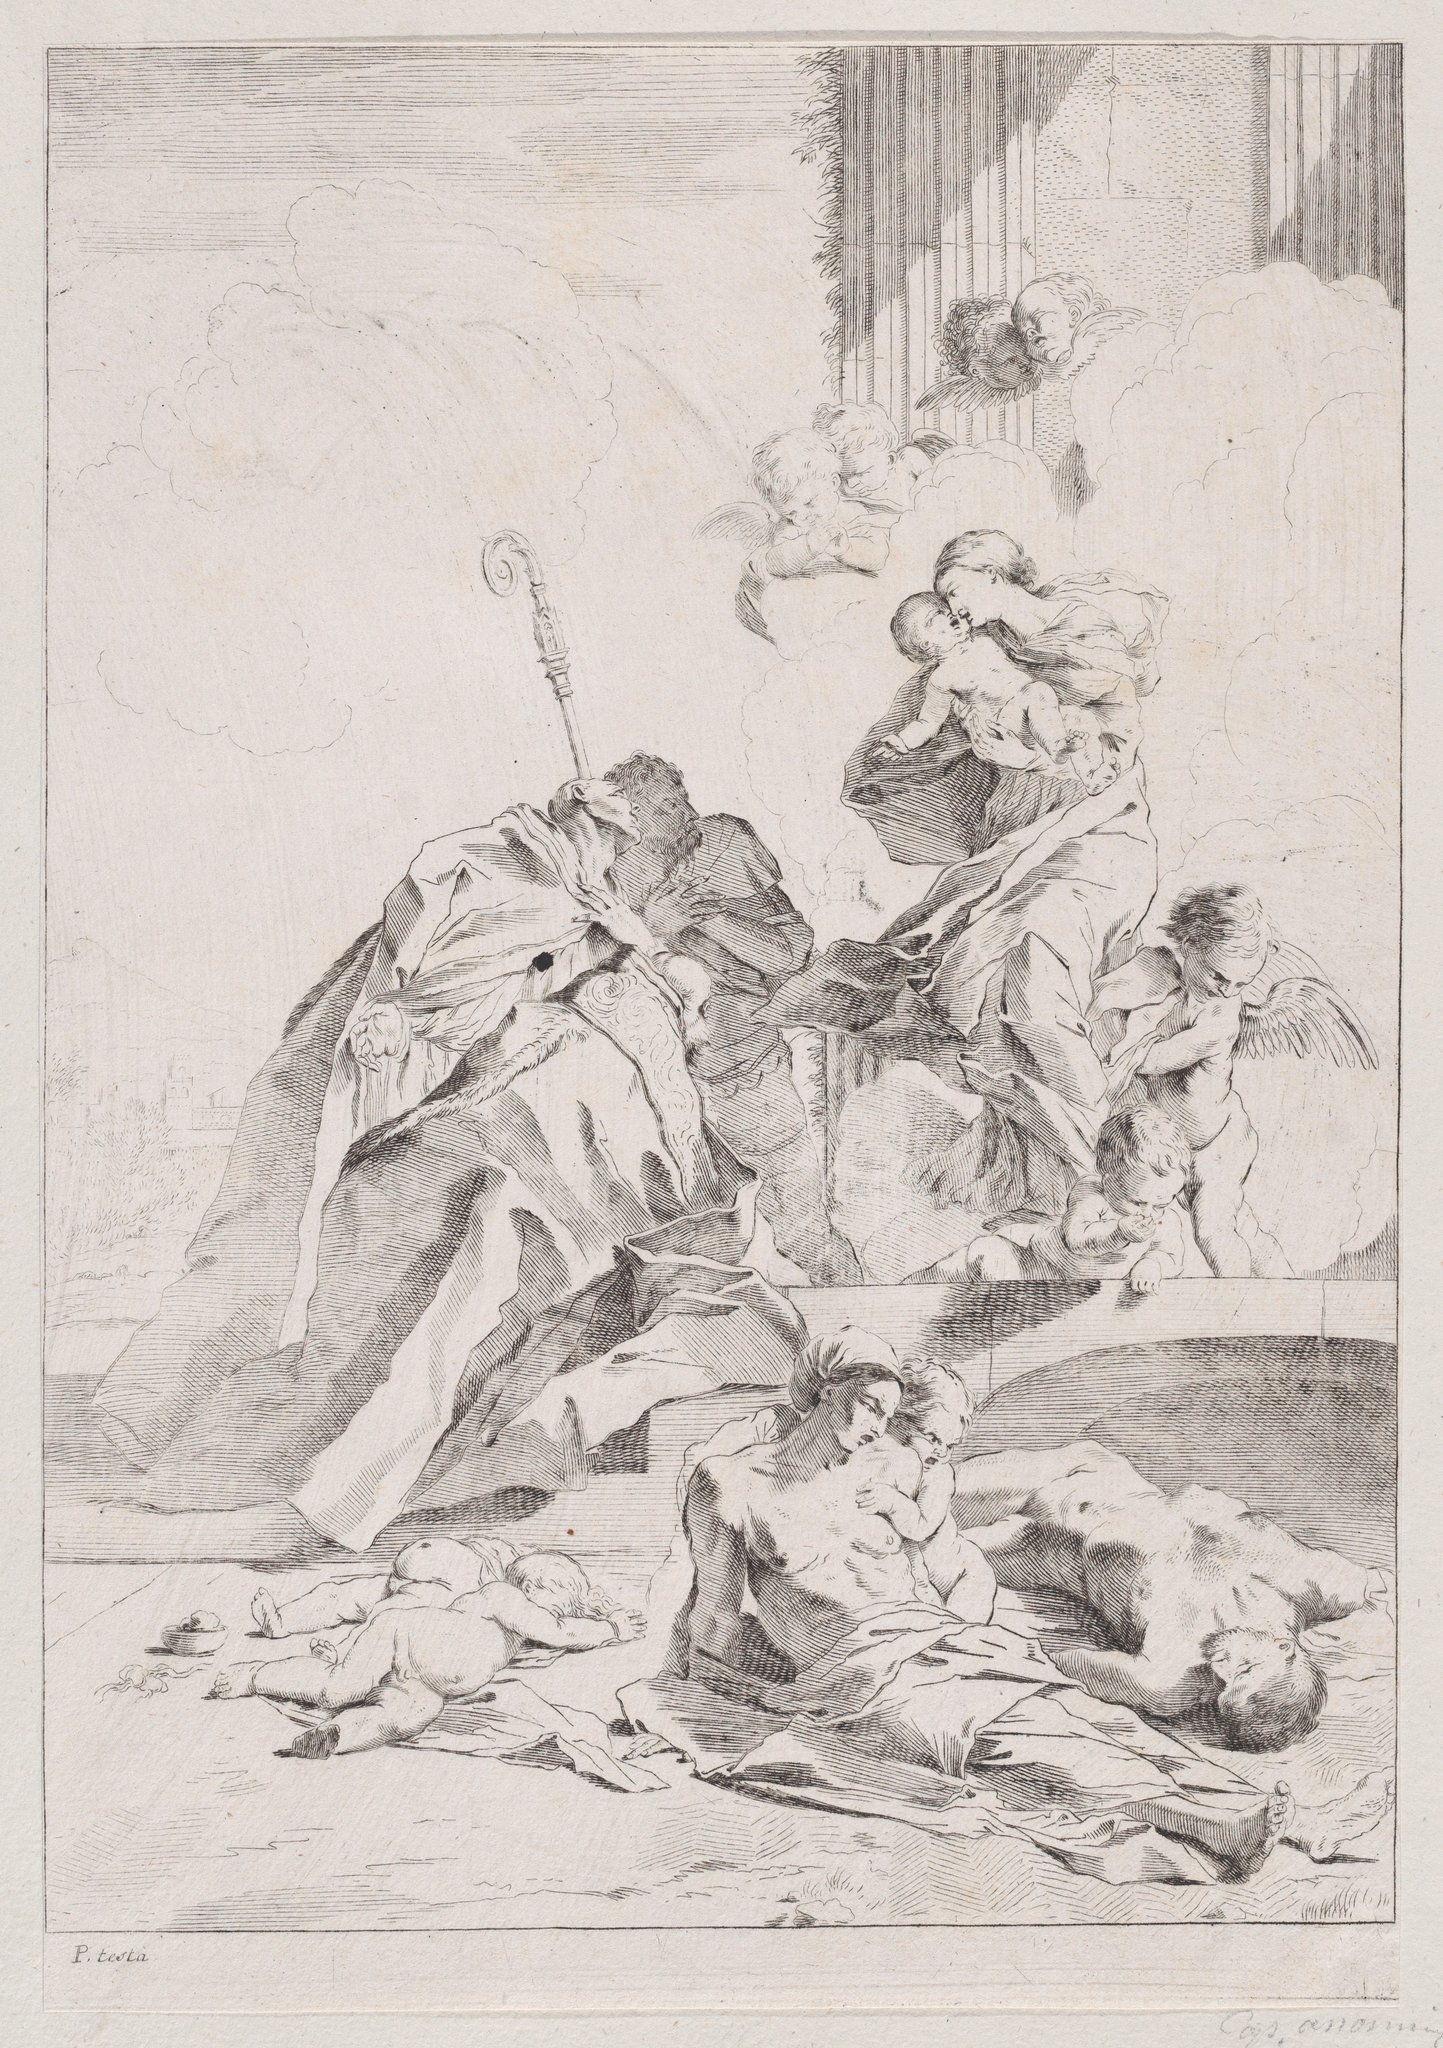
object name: print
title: Three Lucchese saints Sts Nicholas Tolentino, Nicholas of Bari and Roch interceding with the Virgin on behalf of the victims of the plague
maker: anonymous, 17th century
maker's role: artist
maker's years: 1600-1700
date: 1650-1700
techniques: etching